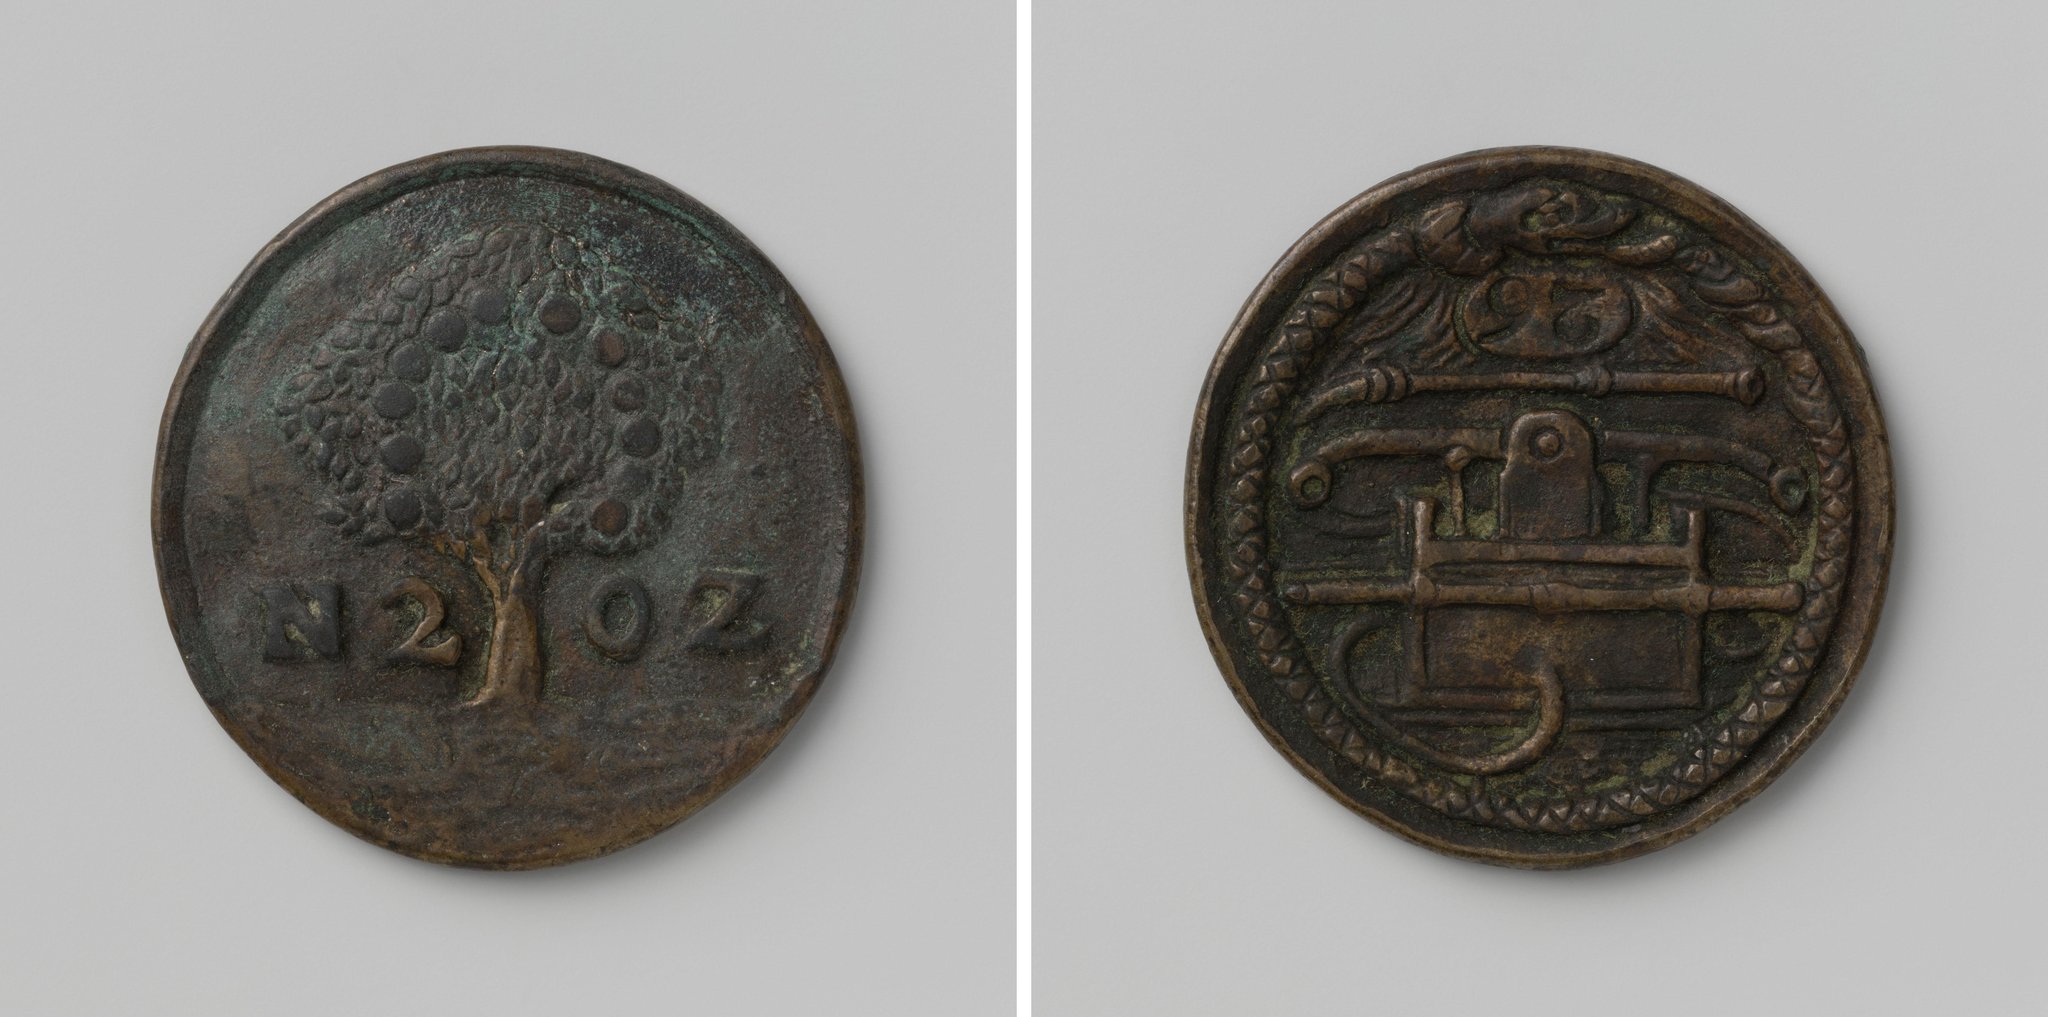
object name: fire engine medal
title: Schellingwoude, brandspuitpenning N 2 met nummer 26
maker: Anonymous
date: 1680-1800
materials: brass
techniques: casting, engraving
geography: schellingwoude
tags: schellingwoude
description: Messing penning. Voorzijde: oranjeboom, waarin twaalf vruchten hangen tussen opschrift N 2 (buitenwijk nummer 2) en O Z (=oostzijde van de Mennonietensloot). Keerzijde: brandspuit onder cartouche, met op kop geplaatst nummer 26, binnen slangerond